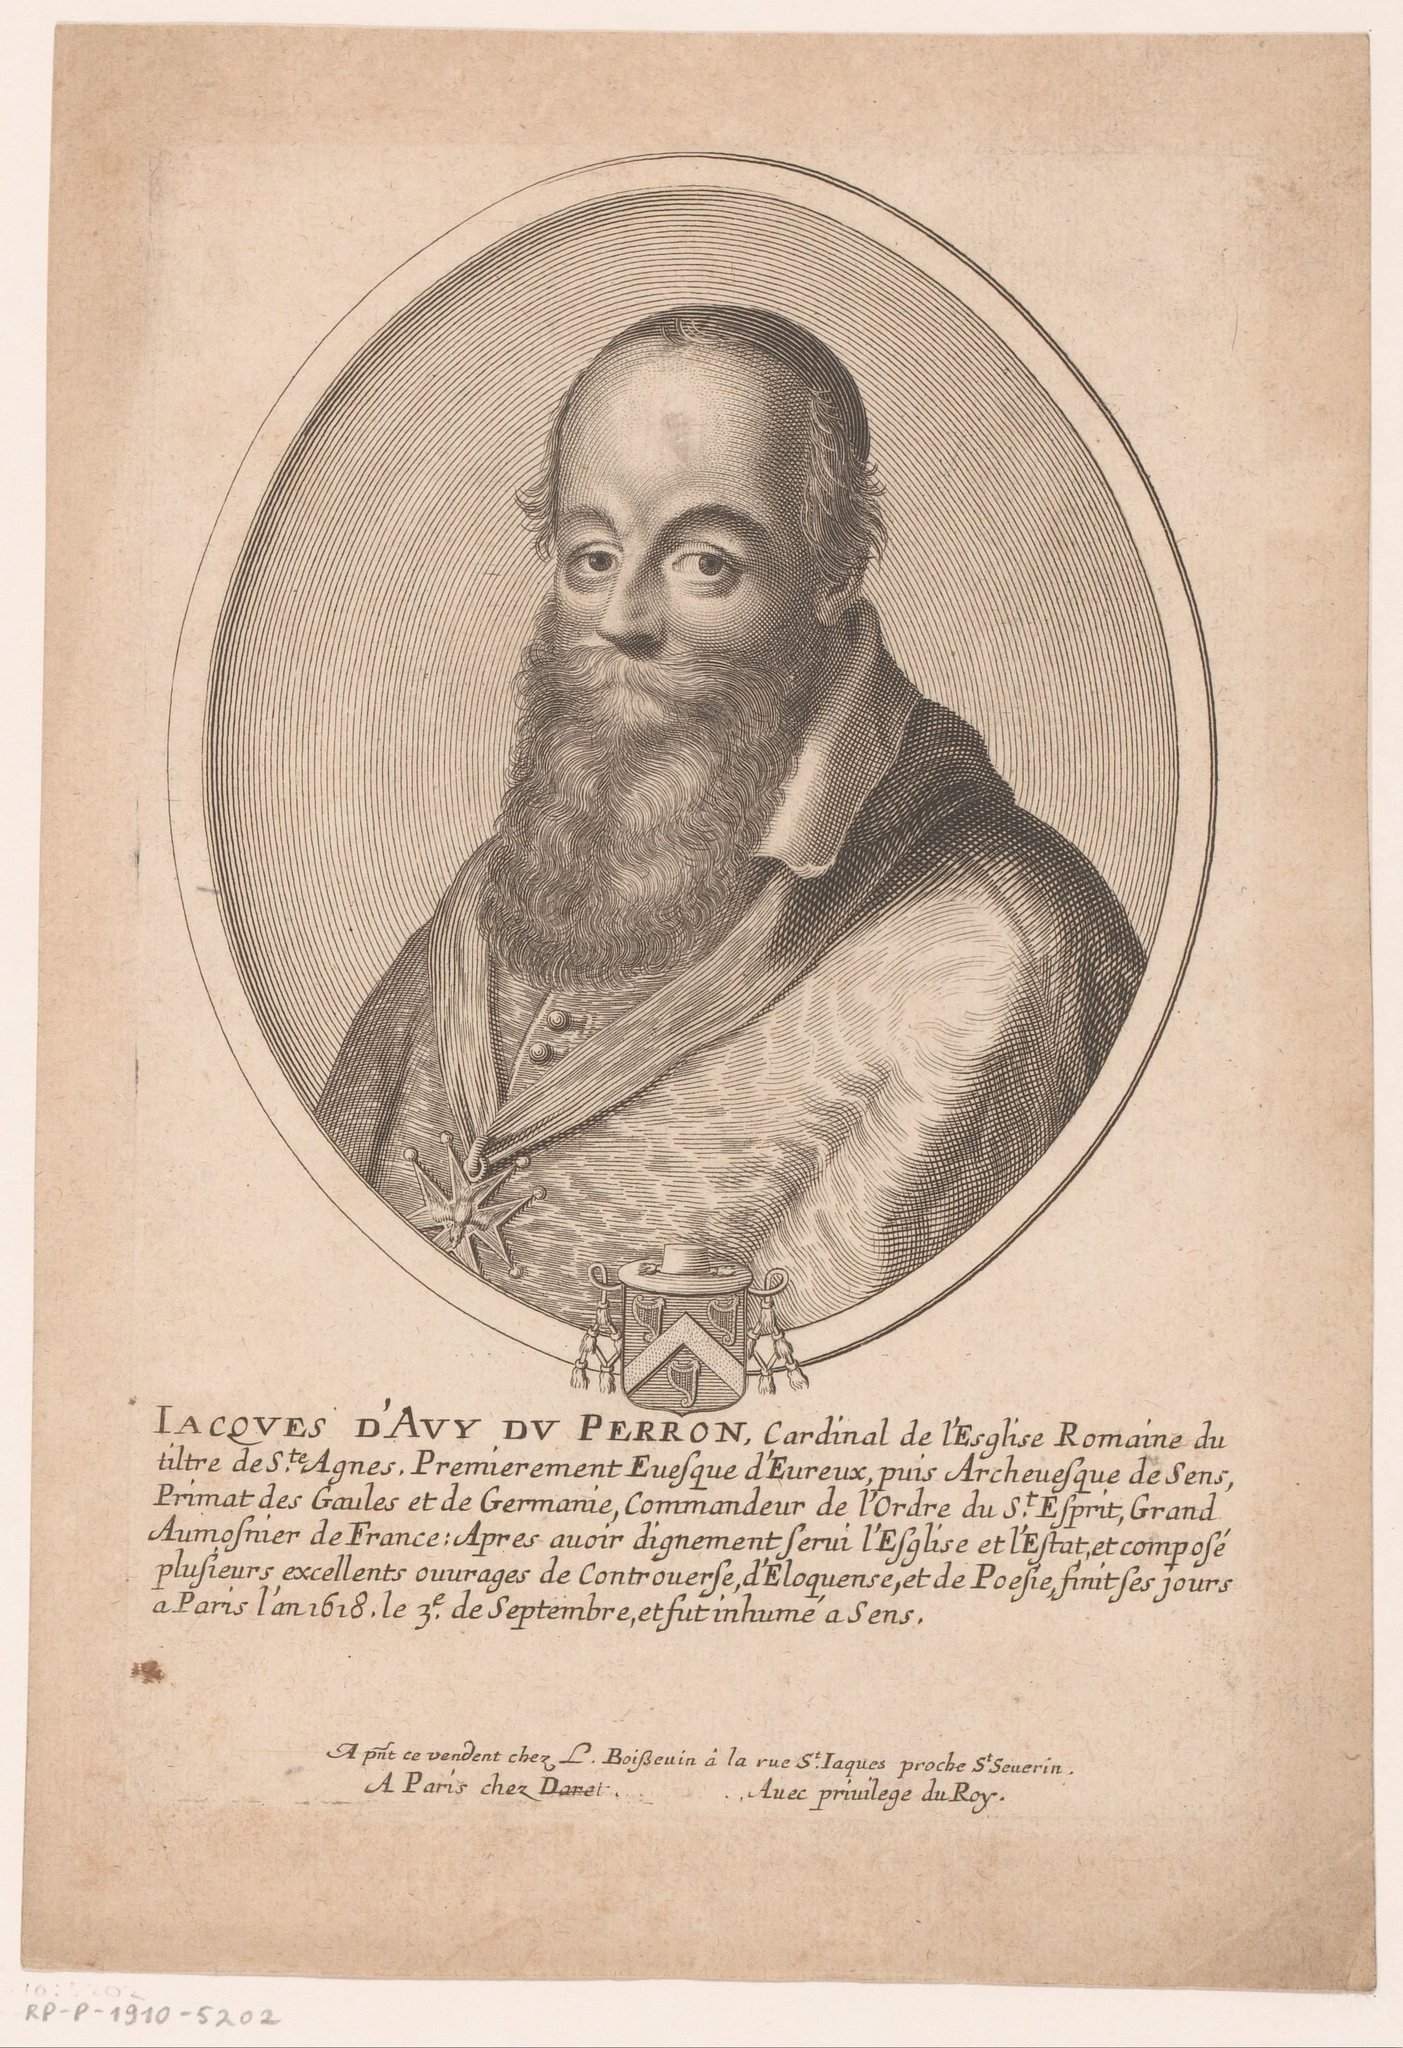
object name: print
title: Portret van Jacques Davy du Perron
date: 1633-1676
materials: paper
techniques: engraving, etching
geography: france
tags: paris, priest, ornament ~ medallion, historical persons, diplomacy, diplomat, writer, poet, author, armorial bearing, heraldry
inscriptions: collector's mark: Lugt 2228